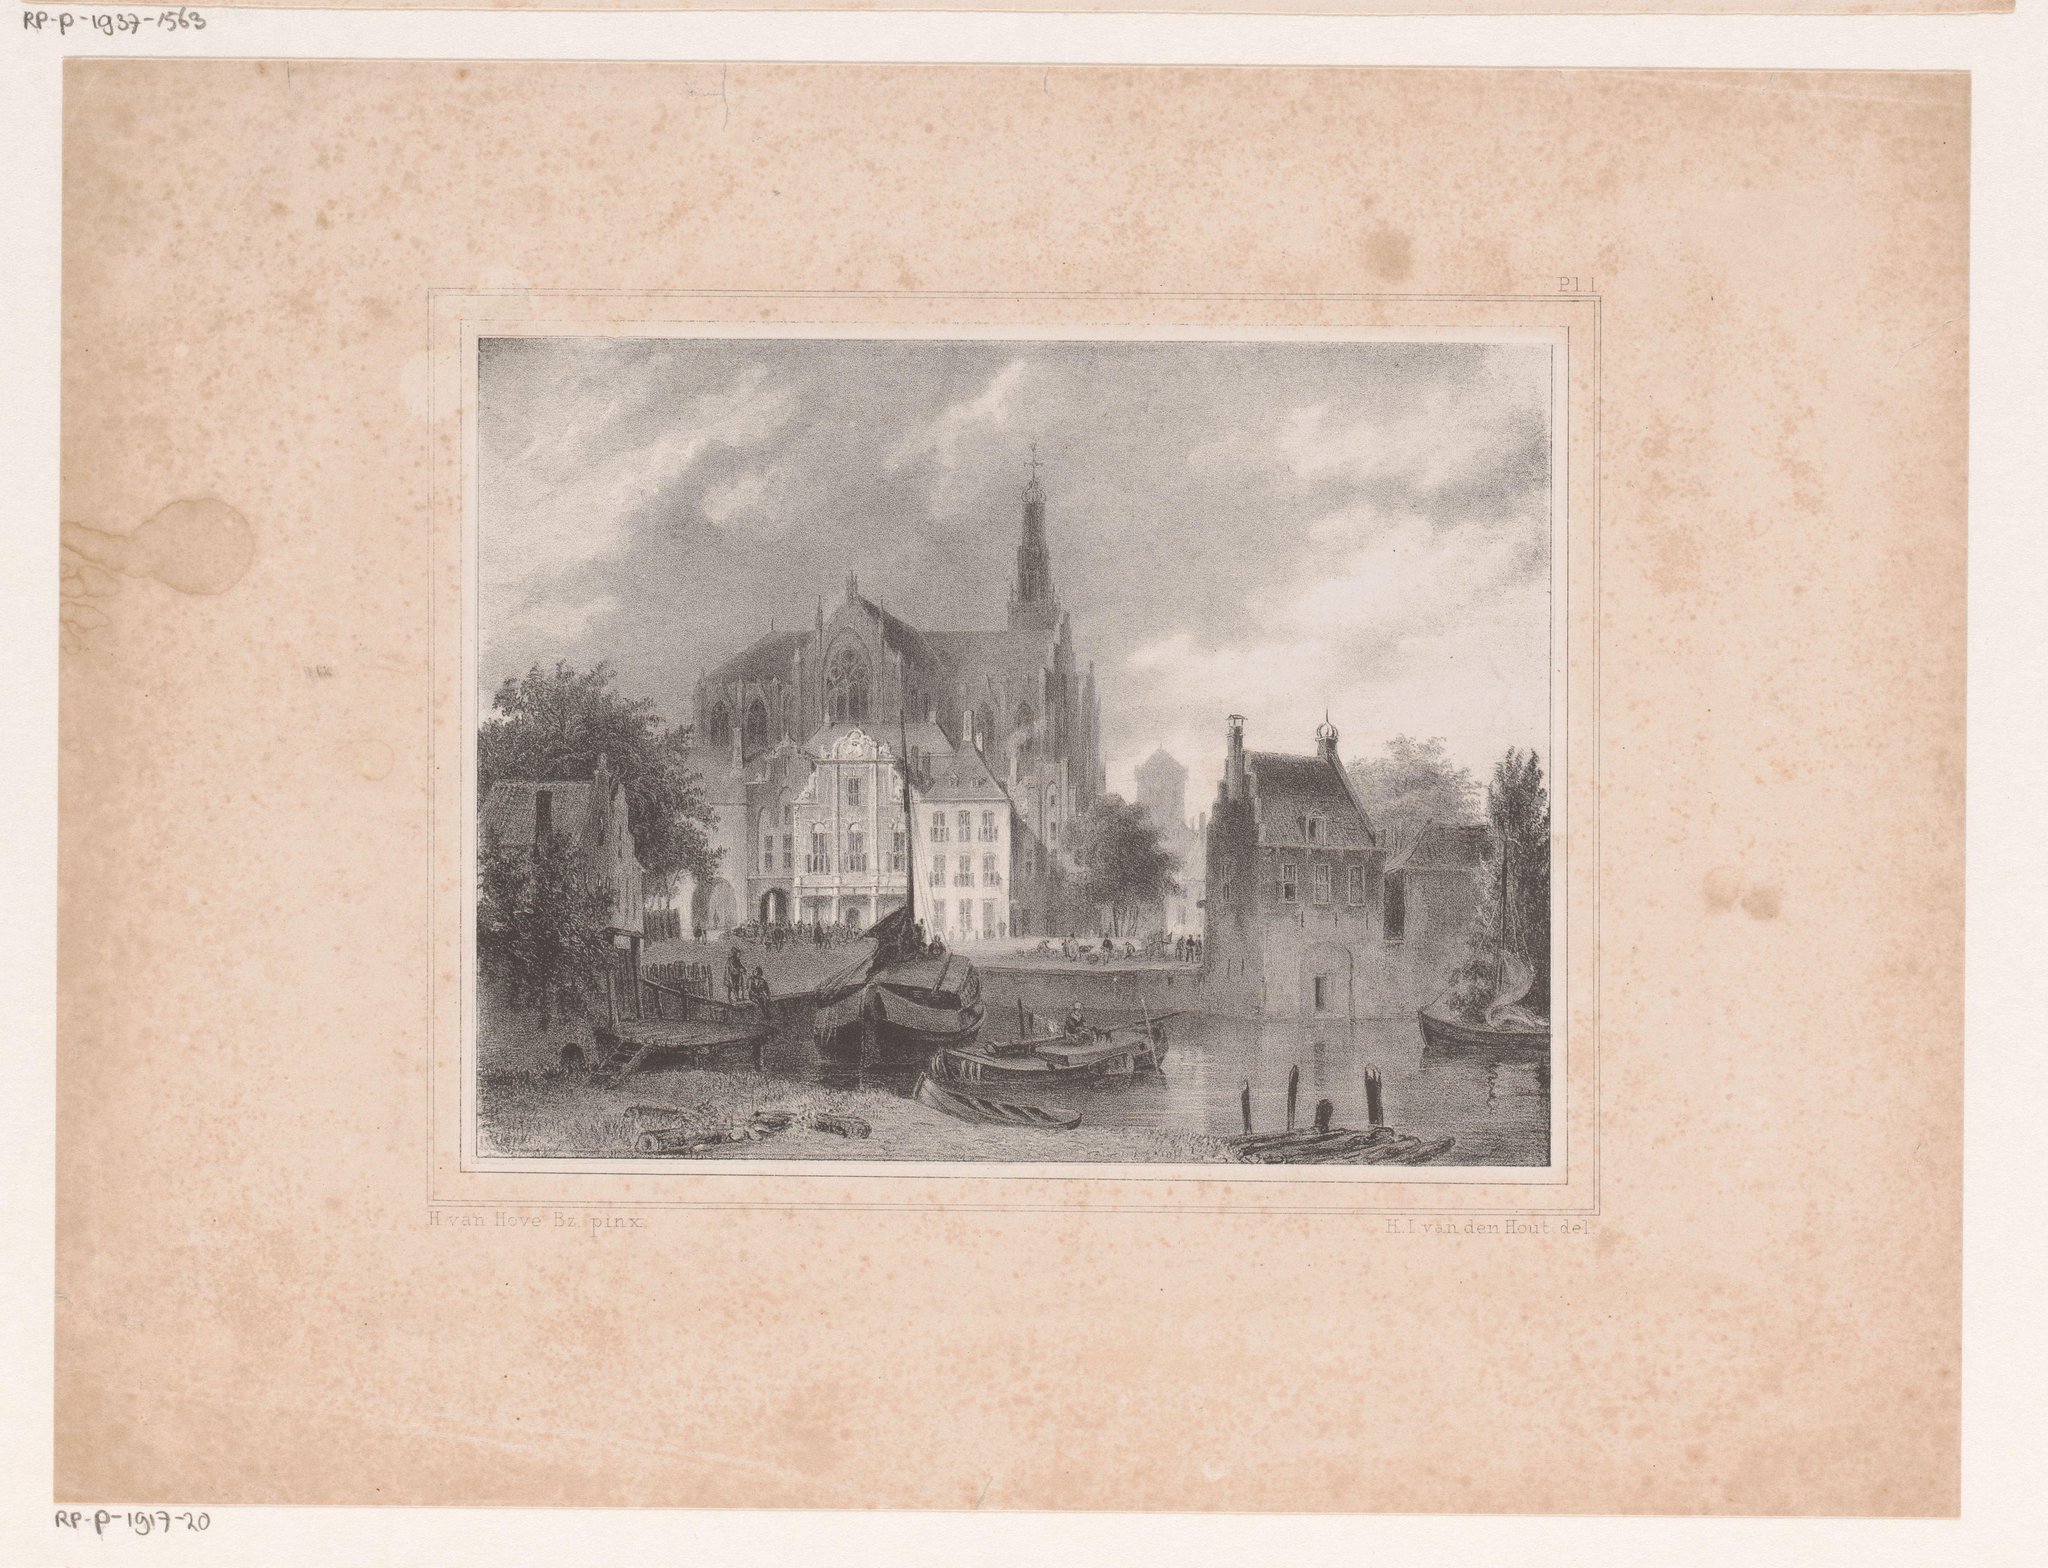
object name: print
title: Stadsgezicht met kerk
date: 1823-1869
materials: paper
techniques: lithograph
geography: netherlands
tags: sailing-ship, sailing-boat, church (exterior), rowing-boat, canoe, etc., city-view, and landscape with man-made constructions (+ city(-scape) with figures, staffage)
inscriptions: collector's mark: Lugt 2228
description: In de voorgrond liggen boten in het water.